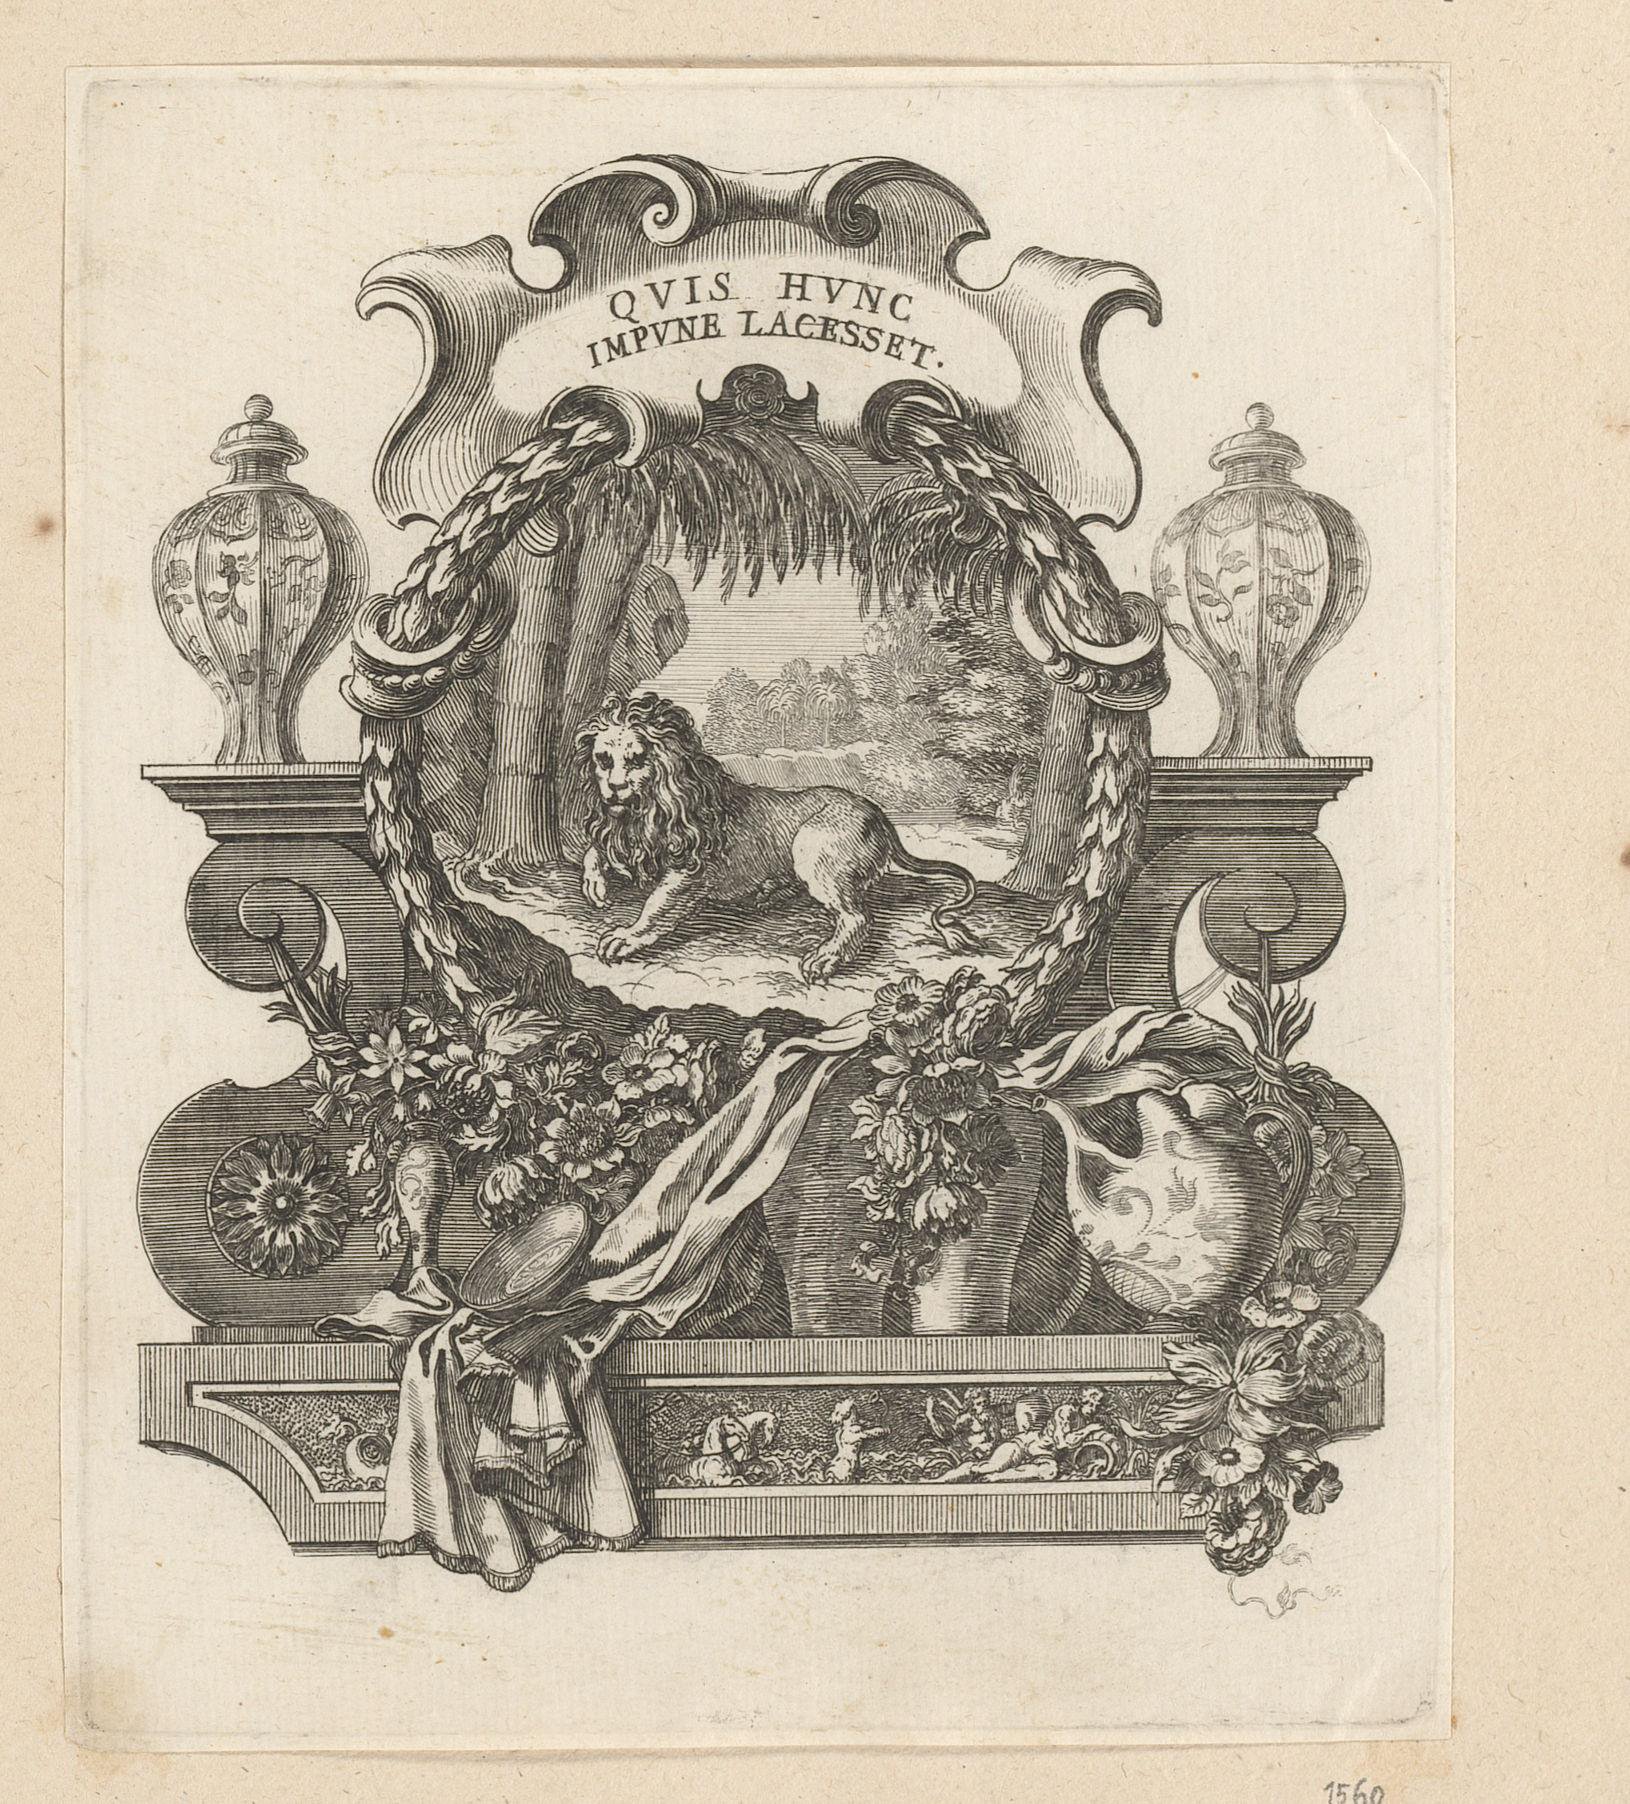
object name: album leaf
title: Quis hunc impune lacesset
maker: sébastien leclerc (i)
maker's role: print maker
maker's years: 1637-1714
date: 1670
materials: paper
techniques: etching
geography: paris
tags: beasts of prey, predatory animals: lion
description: Prent gebruikt voor: Félibien, André. Devises pour les tapisseries du Roy, où sont représentez les quatre éléments et les quatre saisons de l'année (...). Parijs: Imprimerie Royale, 1670.